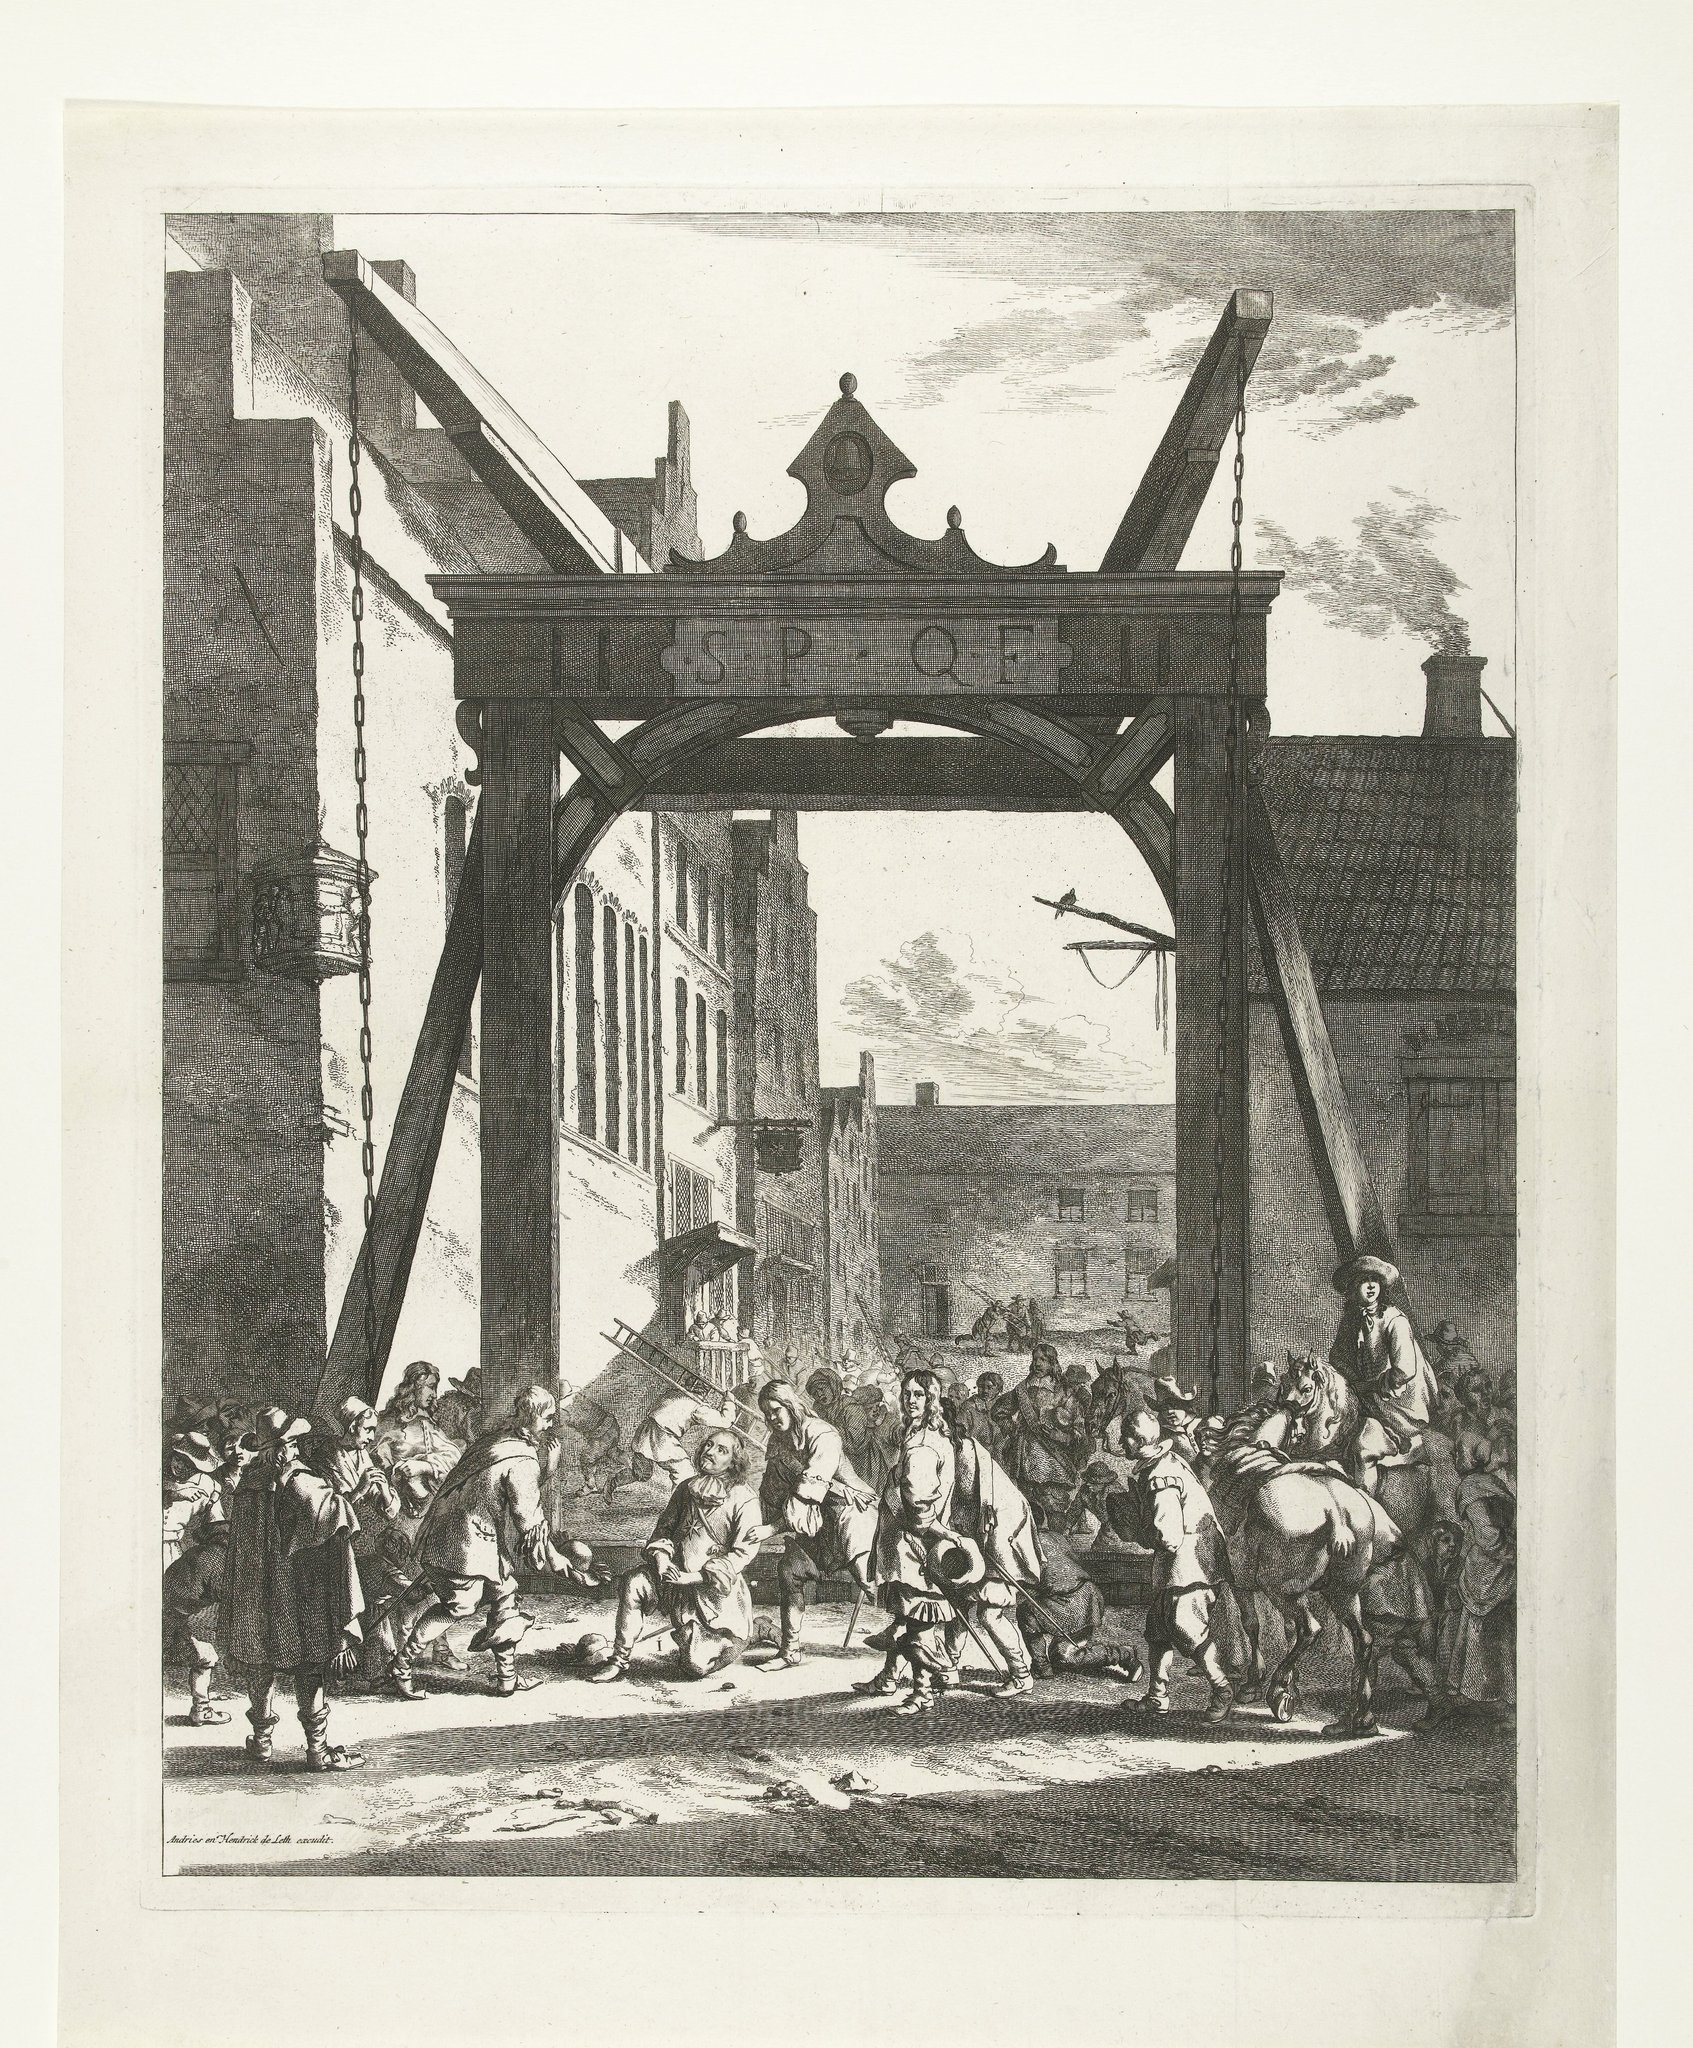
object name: print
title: Dankzegging door graaf Johan Maurits na het ongeluk op de brug van Franeker, 1665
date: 1665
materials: paper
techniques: etching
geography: northern netherlands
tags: johan maurits graaf van nassau-siegen, collapsing building, bridge, accident with horse (or kindred animal), one person praying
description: Dankzegging door graaf Johan Maurits na zijn redding na het ongeluk op de brug van Franeker, 1665, 6 januari 1665. De graaf knielt bij de ingestorte ophaalbrug.